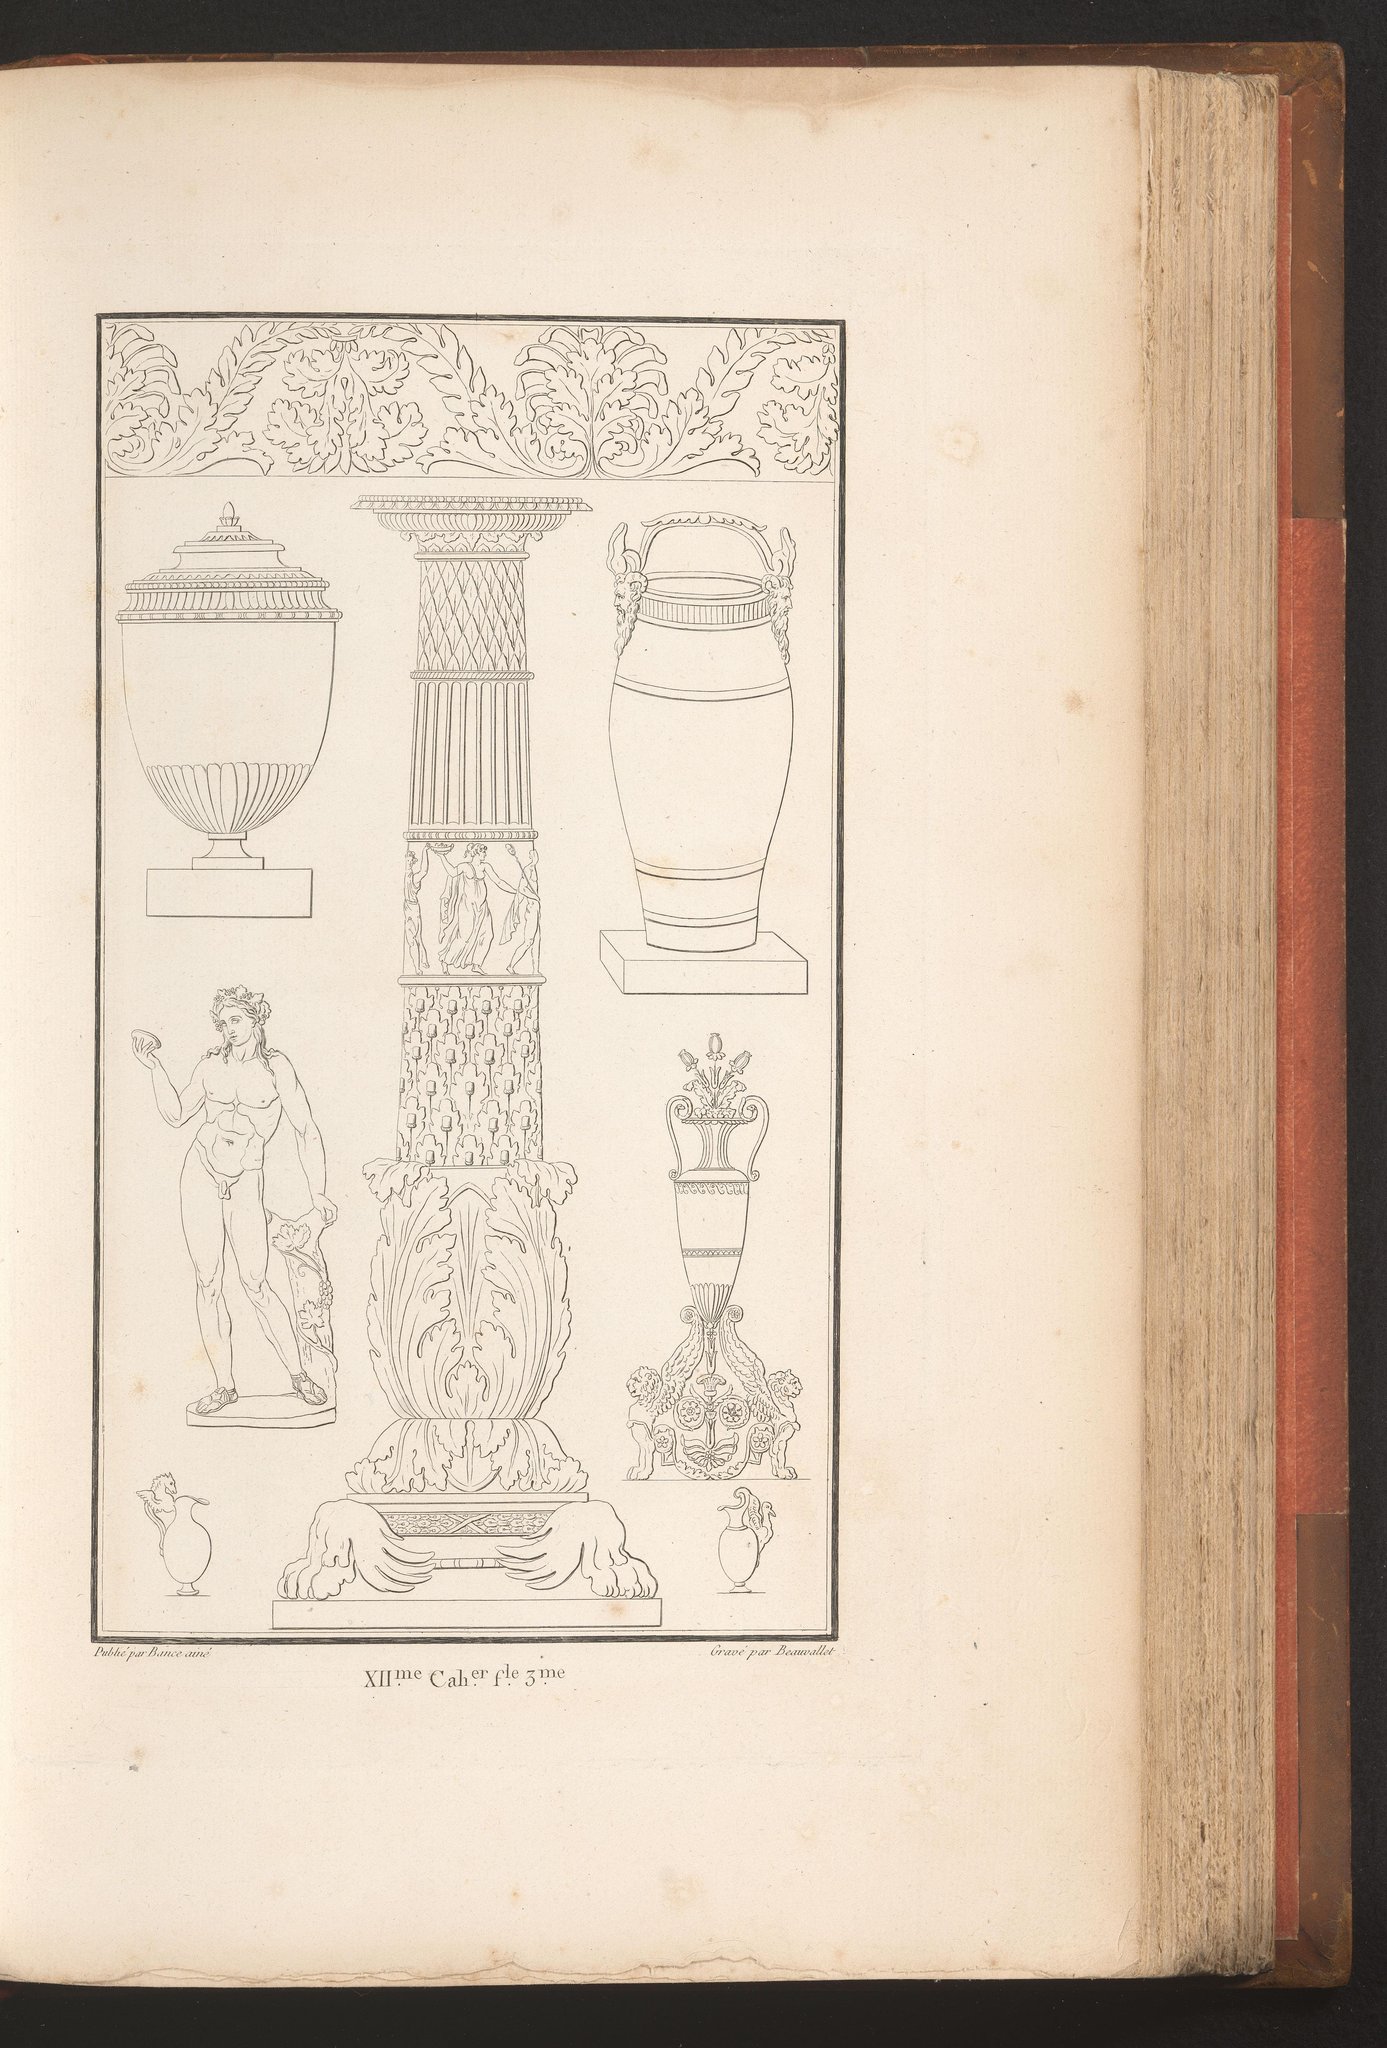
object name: ornament print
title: Diverse ornamenten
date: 1820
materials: paper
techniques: etching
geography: paris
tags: ornaments ~ art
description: Ornamentprent met centraal een schaal op een hoge geornamenteerde voet. Onderdeel van het prentalbum met twee series van in totaal 138 ornamentprenten door Beauvallet en Normand, 'Fragmens d'Ornemens dans le Style Antique'.